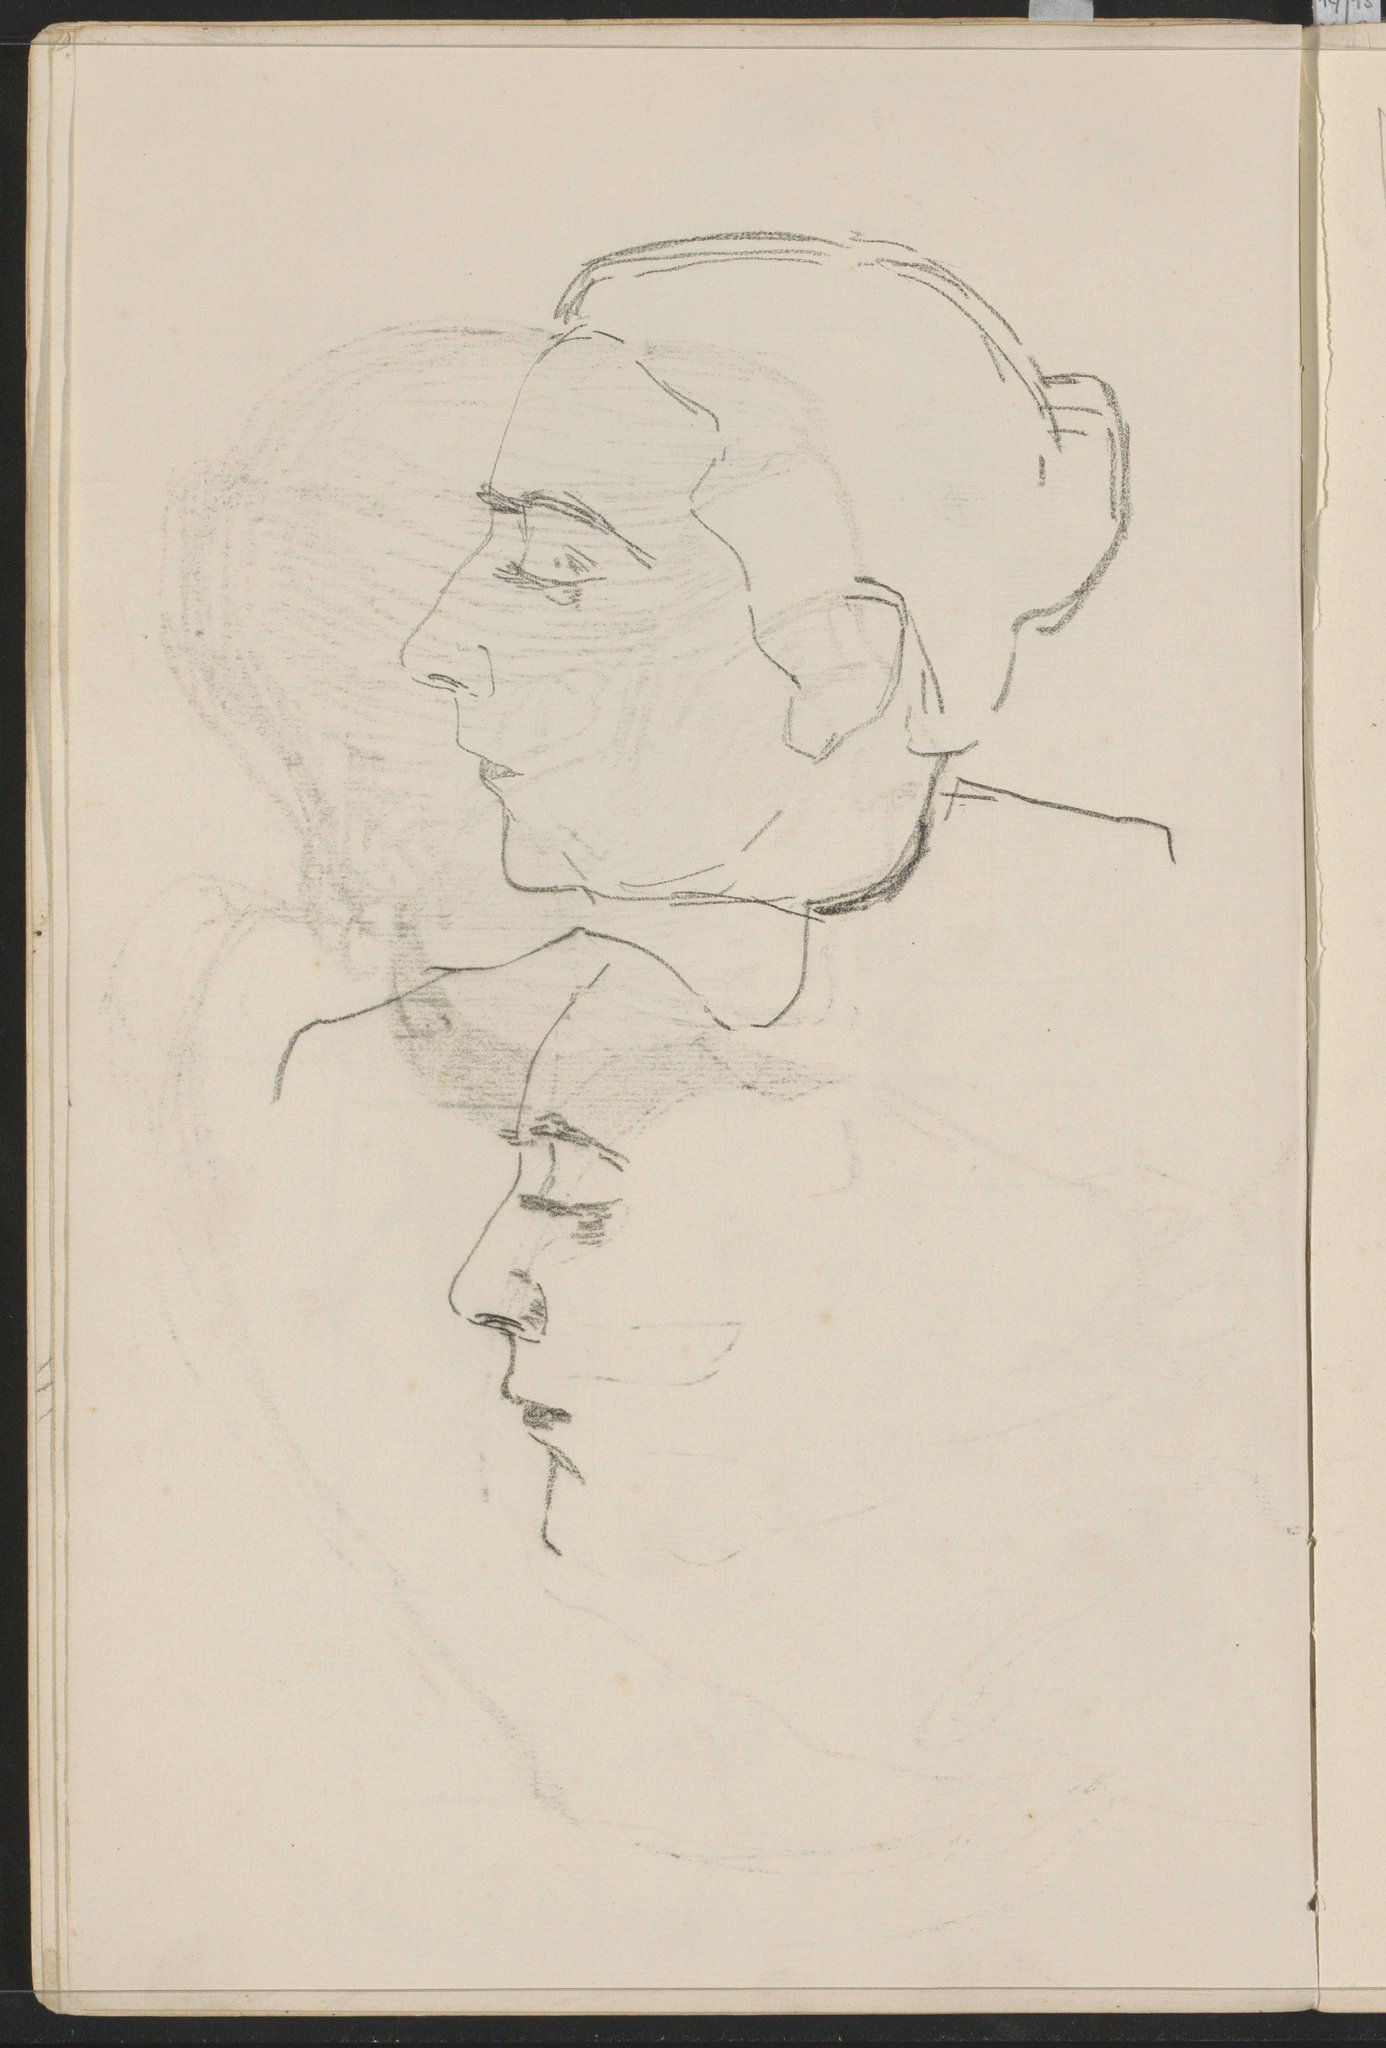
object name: sketchbook leaf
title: Koppen van een vrouw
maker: carel adolph lion cachet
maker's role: draughtsman, print maker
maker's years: 1864-1945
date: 1897-1898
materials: chalk, paper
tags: head (human)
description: Blad 9 verso uit een schetsboek met 29 bladen.